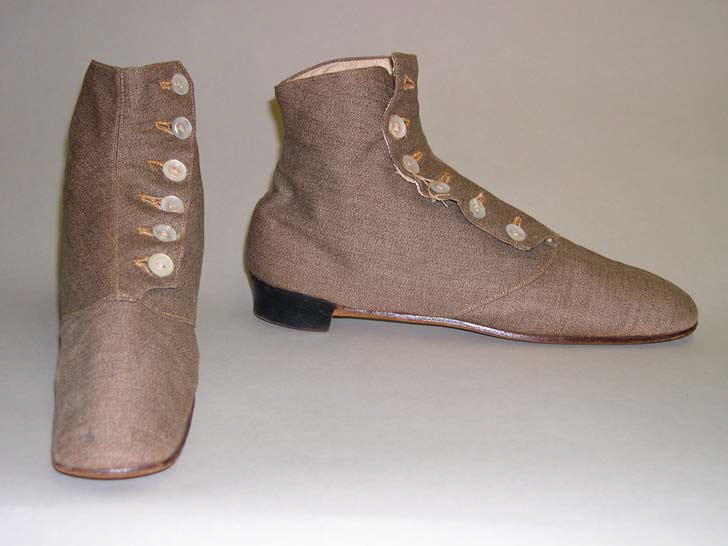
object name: boot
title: Boots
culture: american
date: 1860-1869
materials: cotton, leather